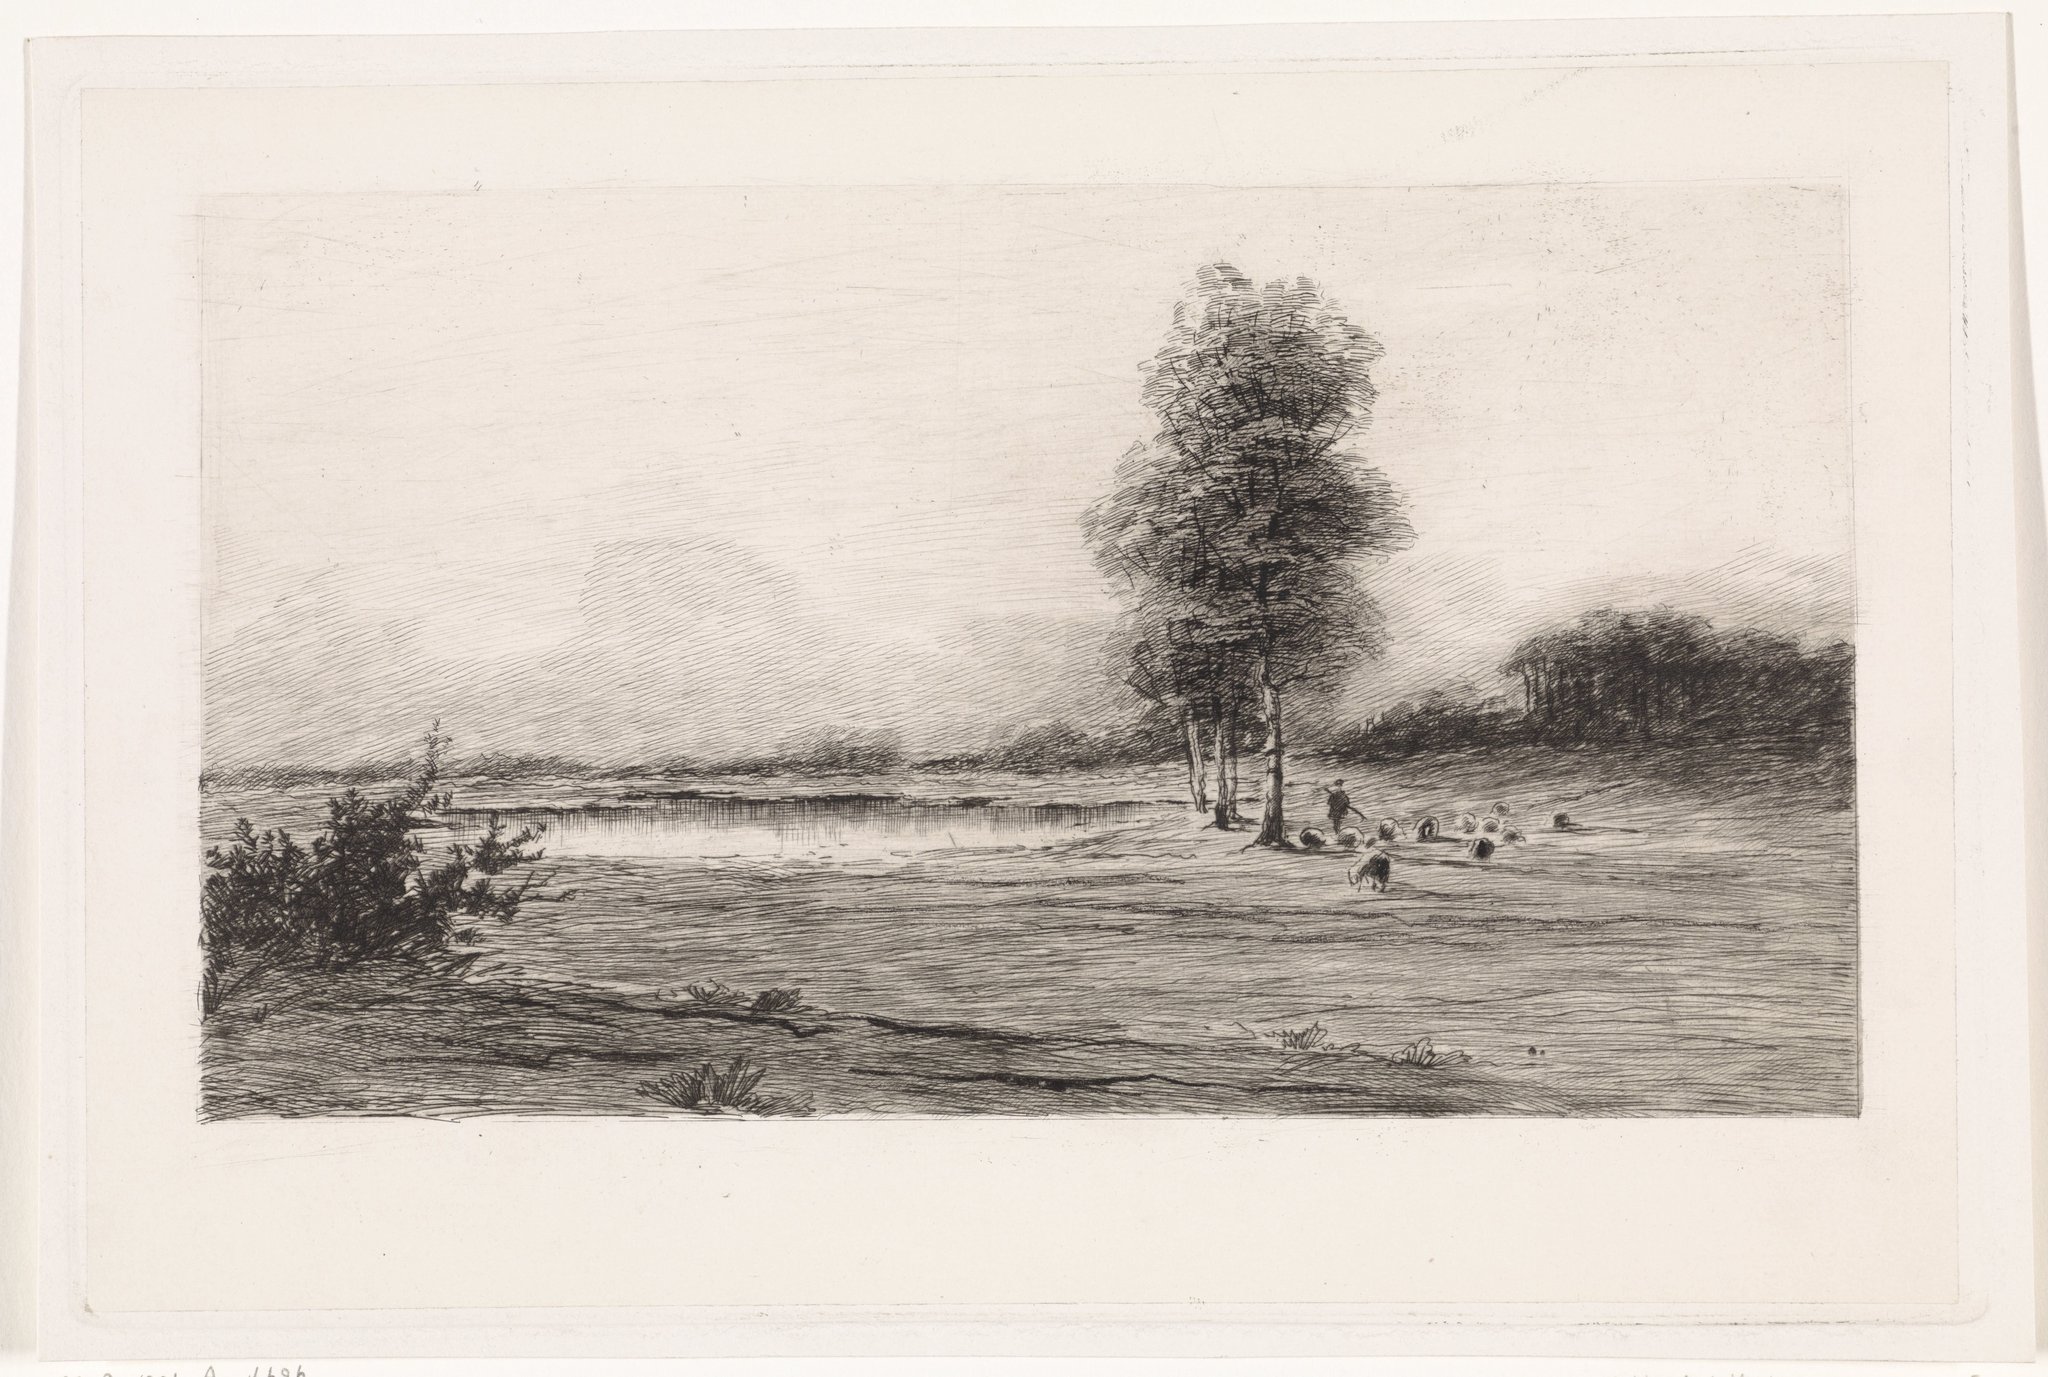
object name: print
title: Landschap met waterplas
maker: elias stark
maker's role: draughtsman, print maker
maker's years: 1849-1933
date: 1801-1891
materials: chalk, paper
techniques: etching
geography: nieuwer-amstel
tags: herding, herdsman, herdswoman, shepherd, shepherdess, cowherd, etc., pond, pool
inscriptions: collector's mark: Lugt 2228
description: Landschap met een waterplas. Bij enkele bomen staat een herder met zijn schapen.